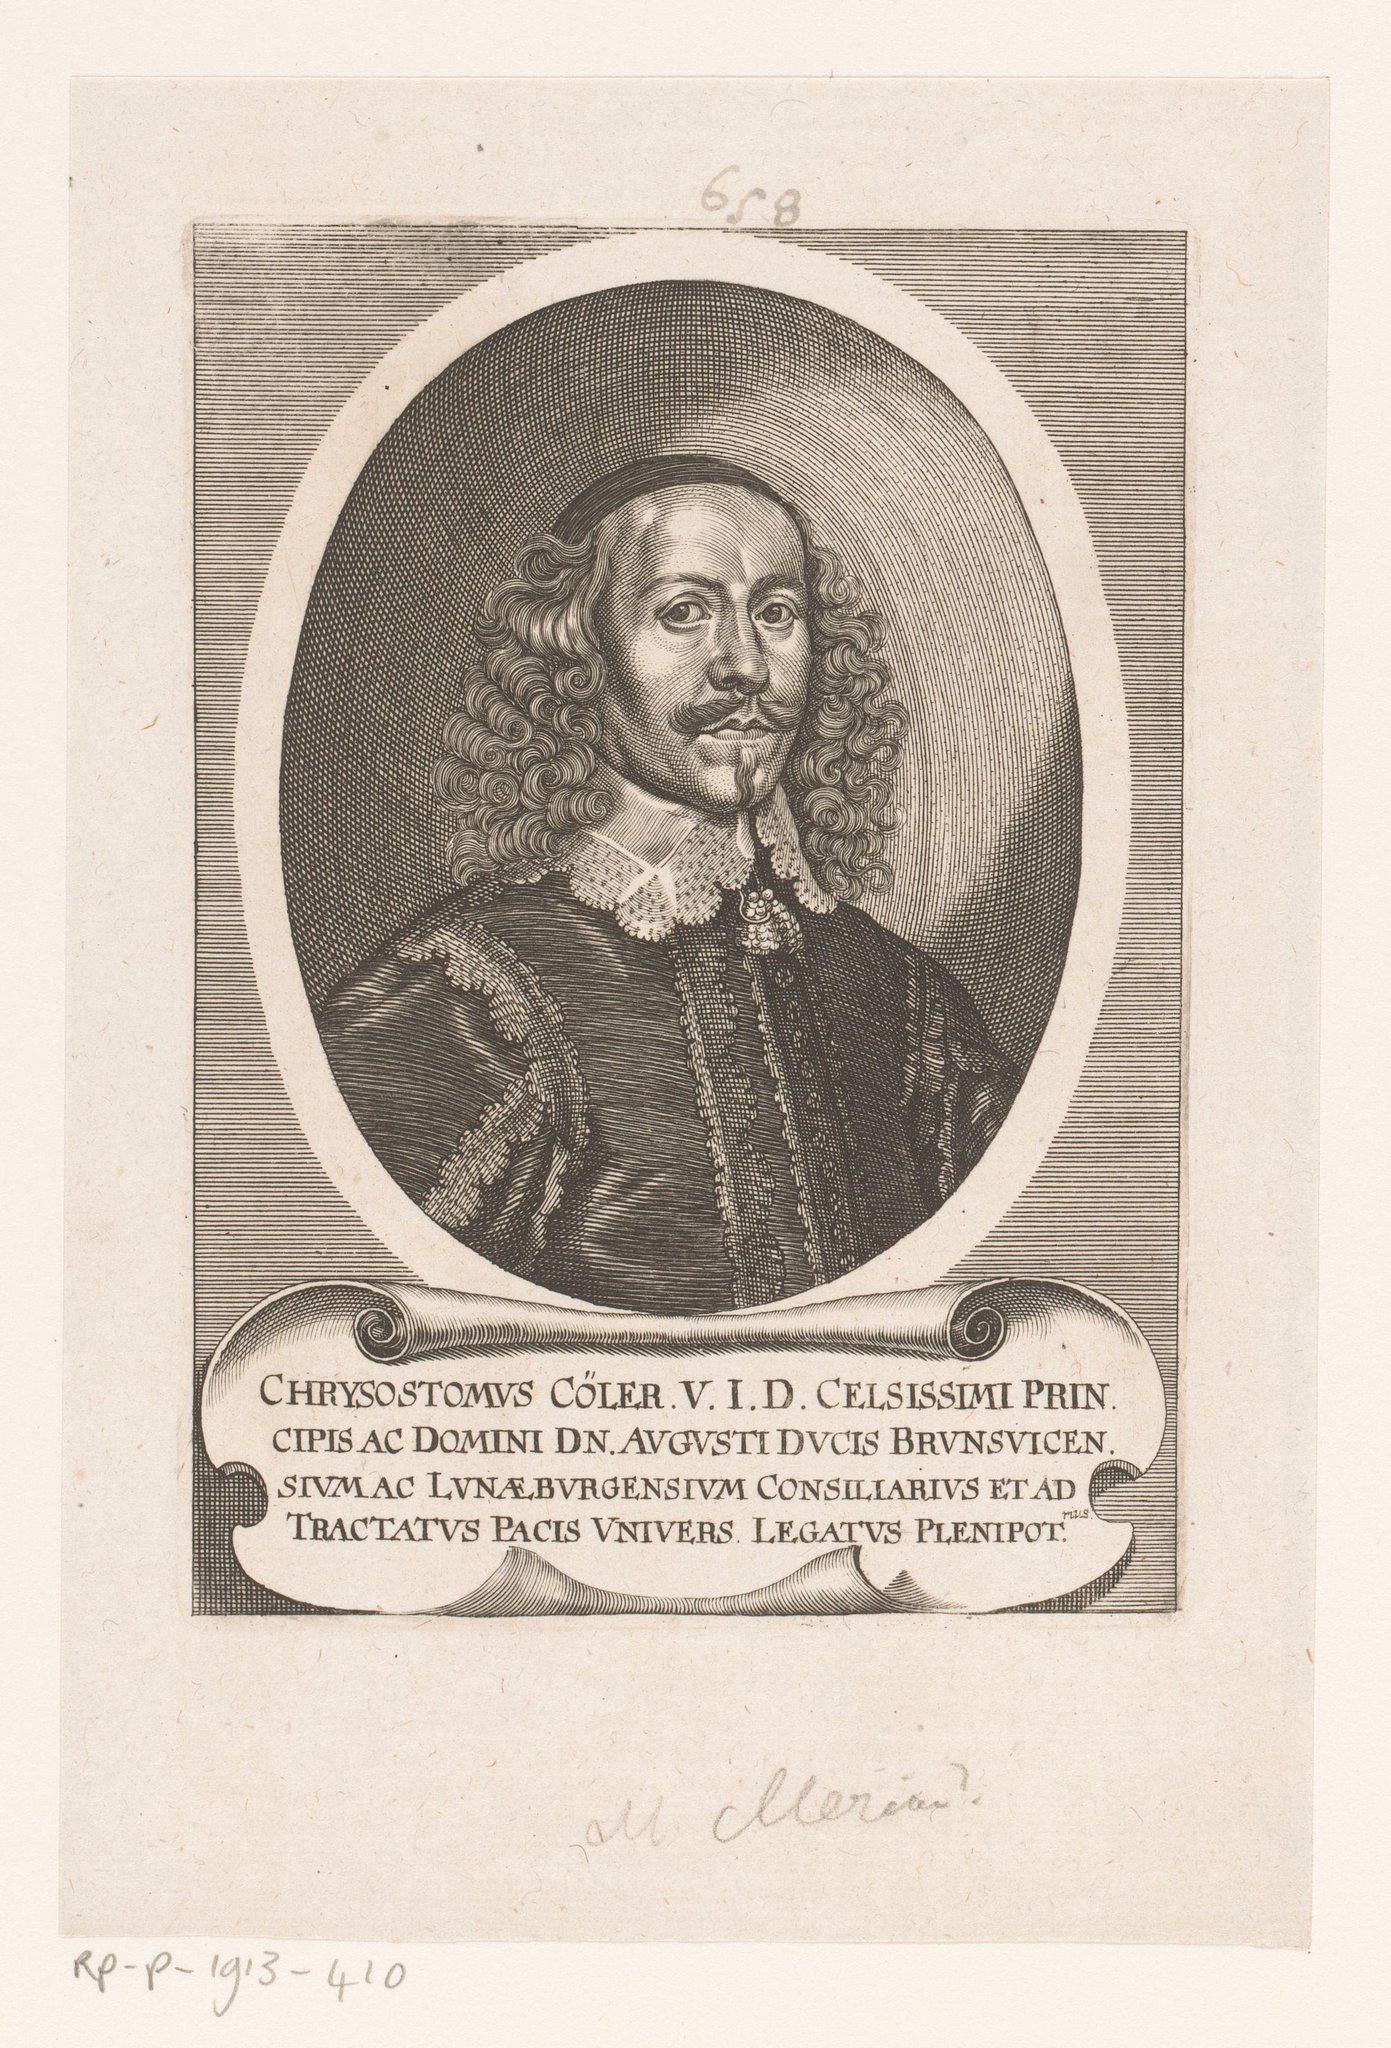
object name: book illustration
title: Portret van Chrysostomus Cöler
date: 1652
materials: paper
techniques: engraving, etching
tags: historical persons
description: Illustratie in: J.G. Schleder. Theatrum Europaeum. Dl. 6. Frankfurt a.M., Merian, 1652. P. 658.